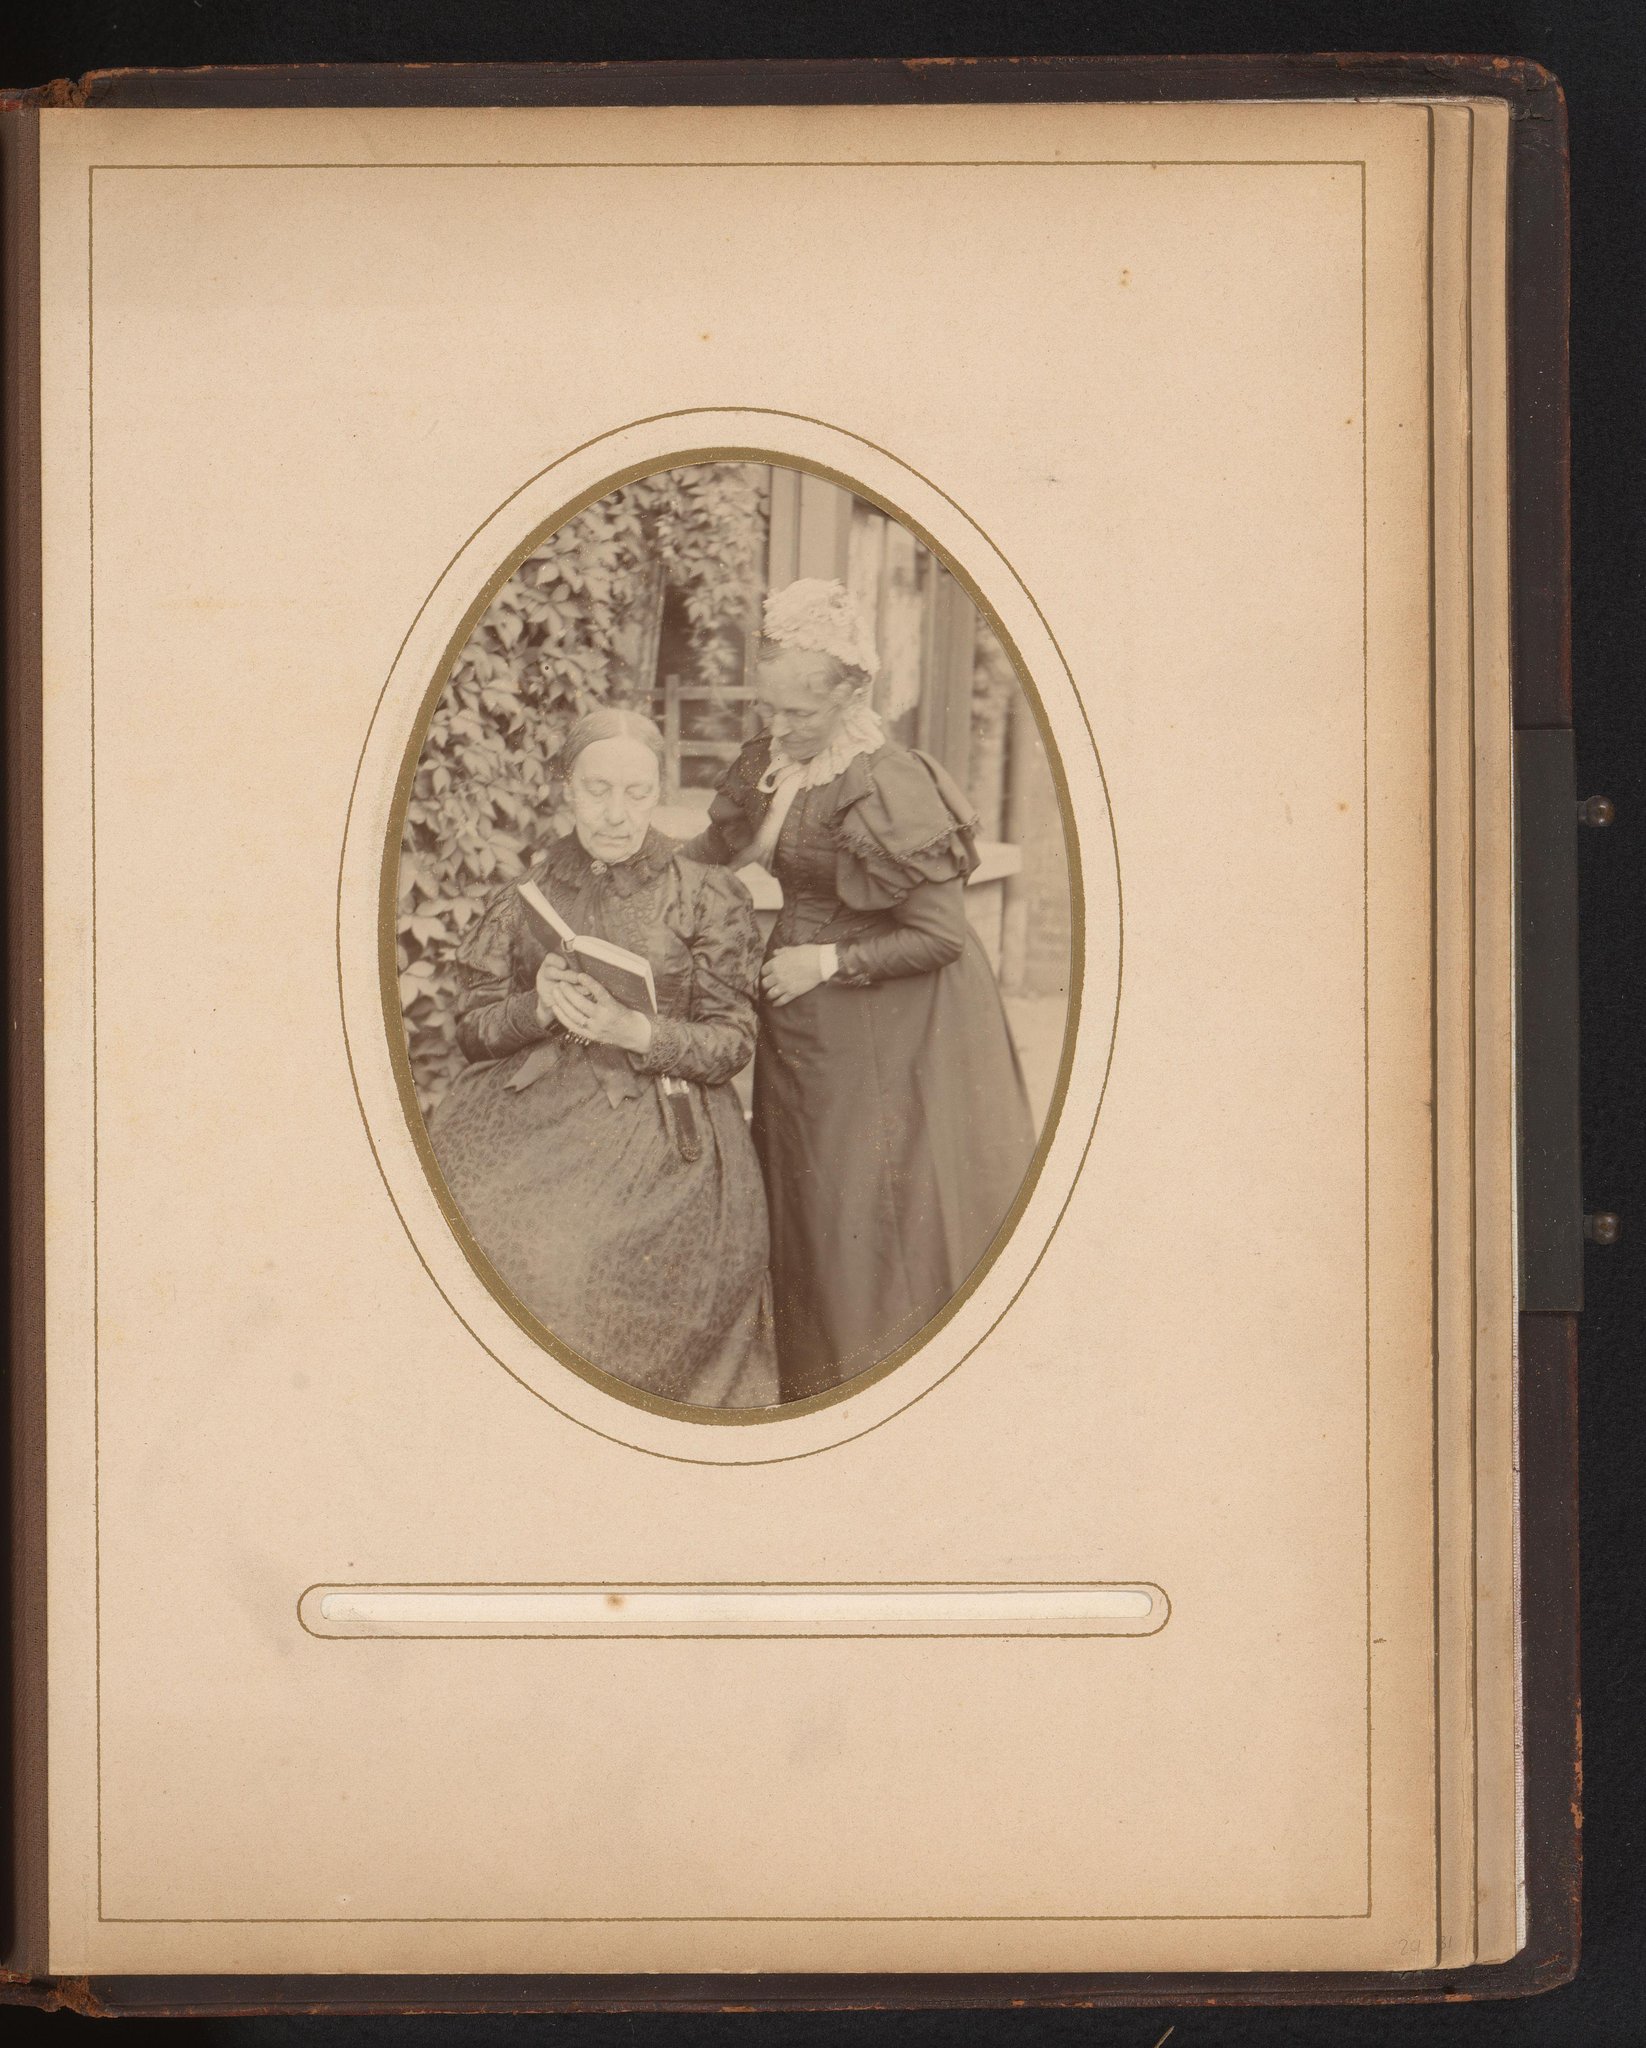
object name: photograph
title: Portret van twee vrouwen met een boek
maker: w.w. winter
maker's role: fotograaf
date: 1860-1900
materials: photographic support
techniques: albumen print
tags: adult woman, reading, historical persons